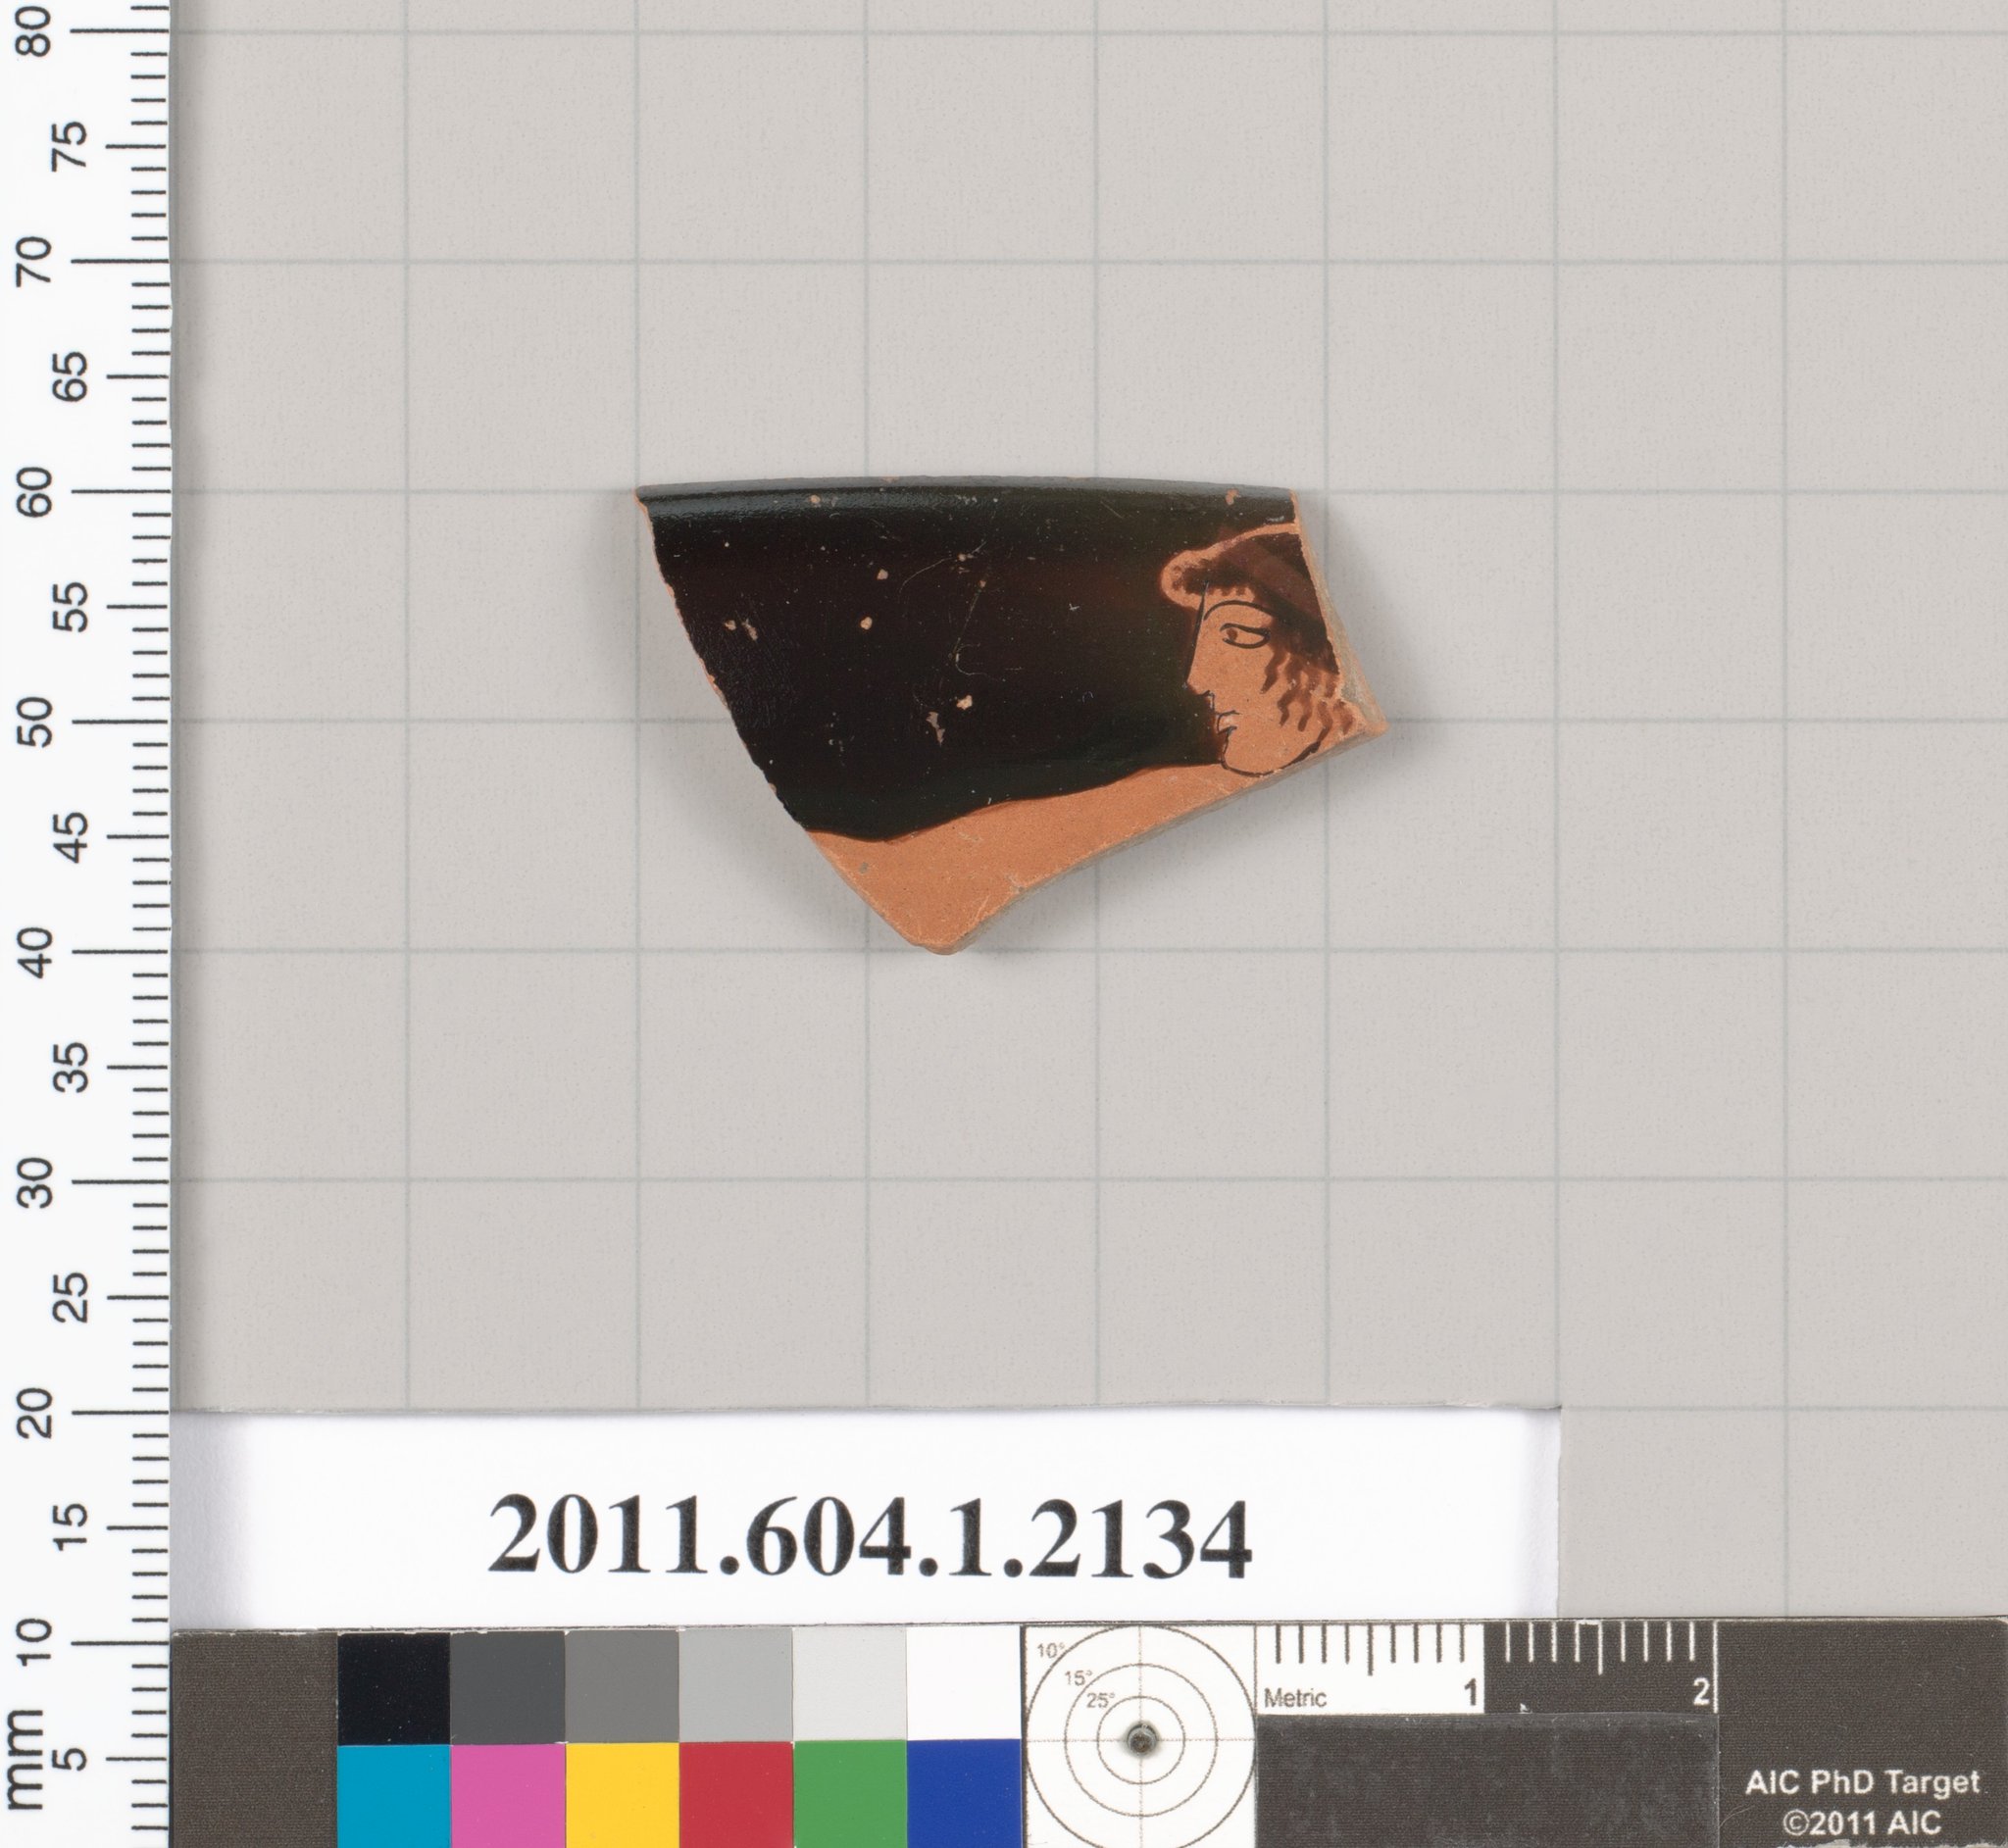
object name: kylix fragment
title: Terracotta rim fragment of a kylix (drinking cup)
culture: greek, attic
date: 460-450 BCE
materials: terracotta